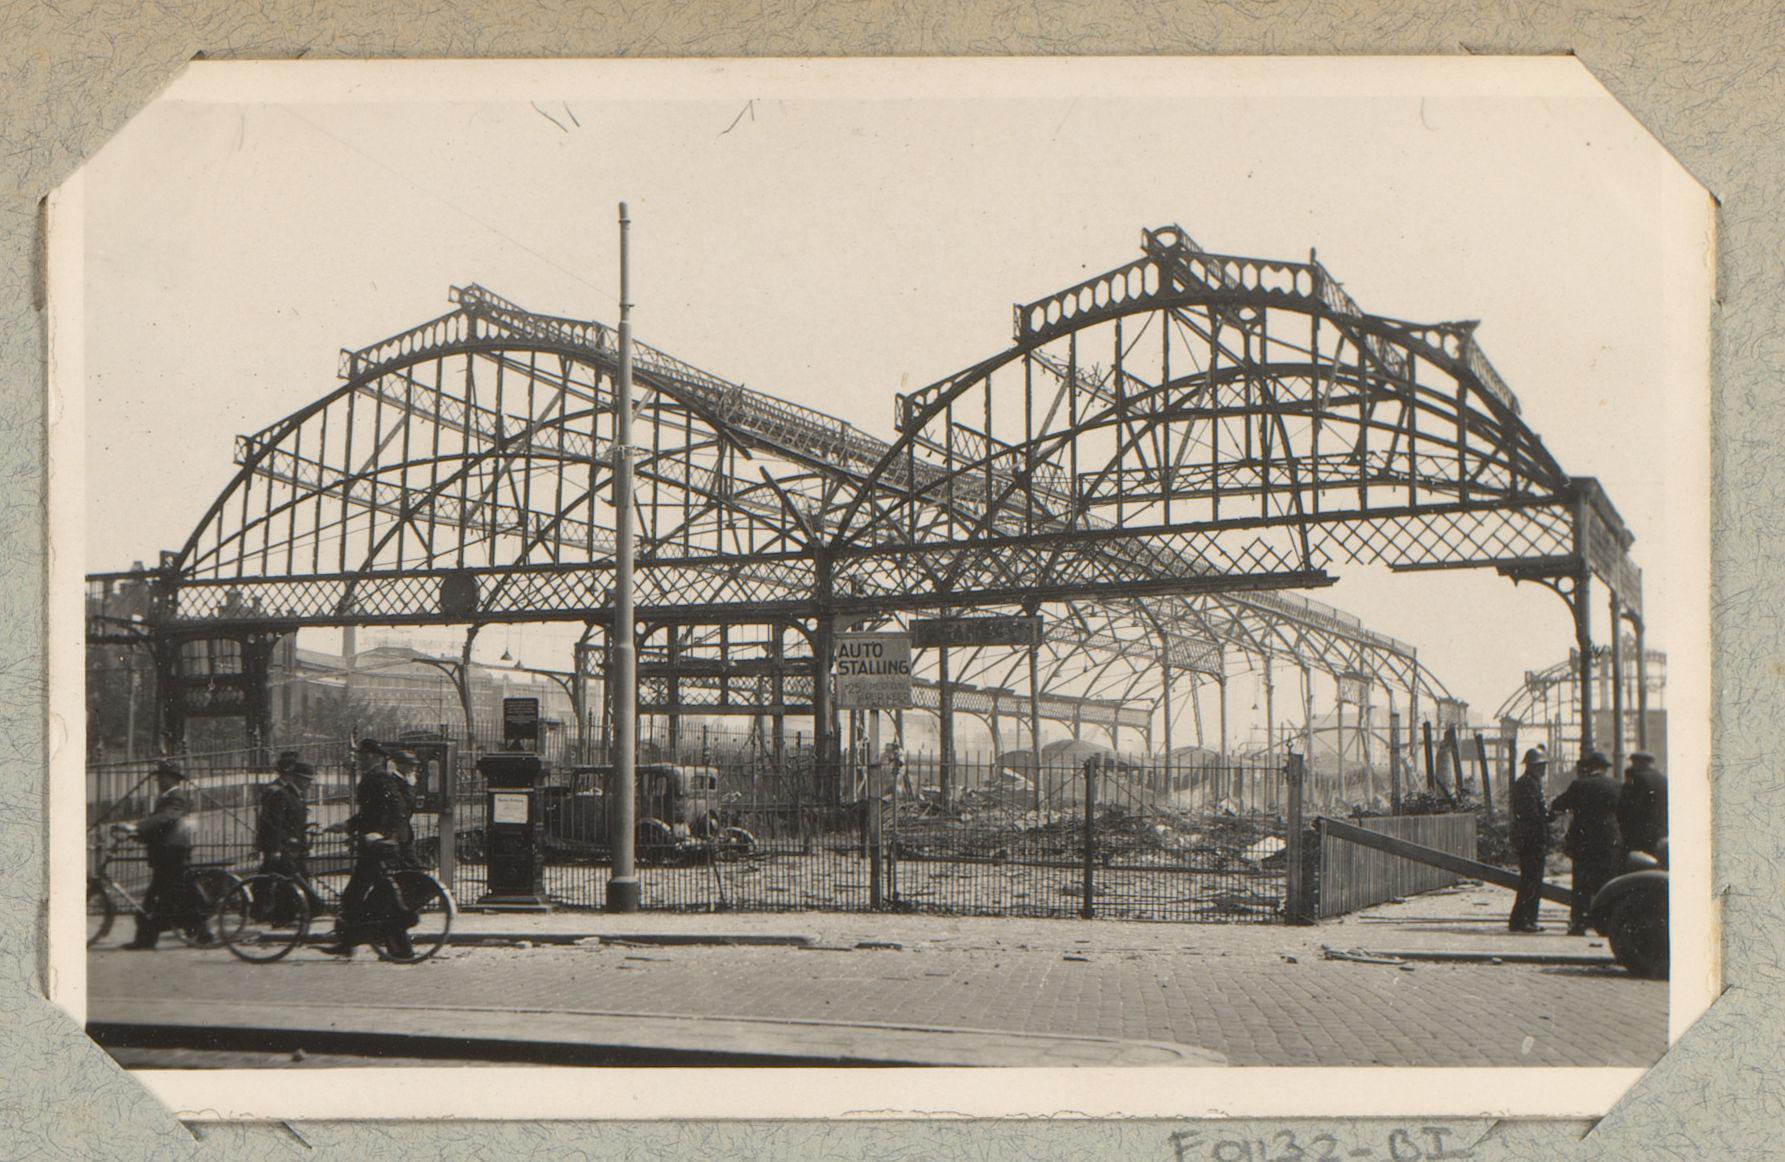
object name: photograph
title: Geraamtes van het Maasstation te Rotterdam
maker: j. nolte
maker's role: fotograaf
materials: photographic support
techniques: gelatin silver print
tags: devastated, ruined place or city (~ warfare), ruin of a dwelling, house, castle, etc., rotterdam, rotterdam blitz